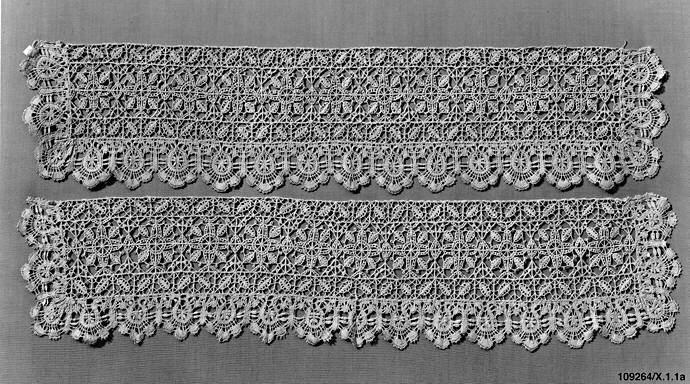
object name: cuff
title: Cuff (one of a pair)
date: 1501-1600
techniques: lace